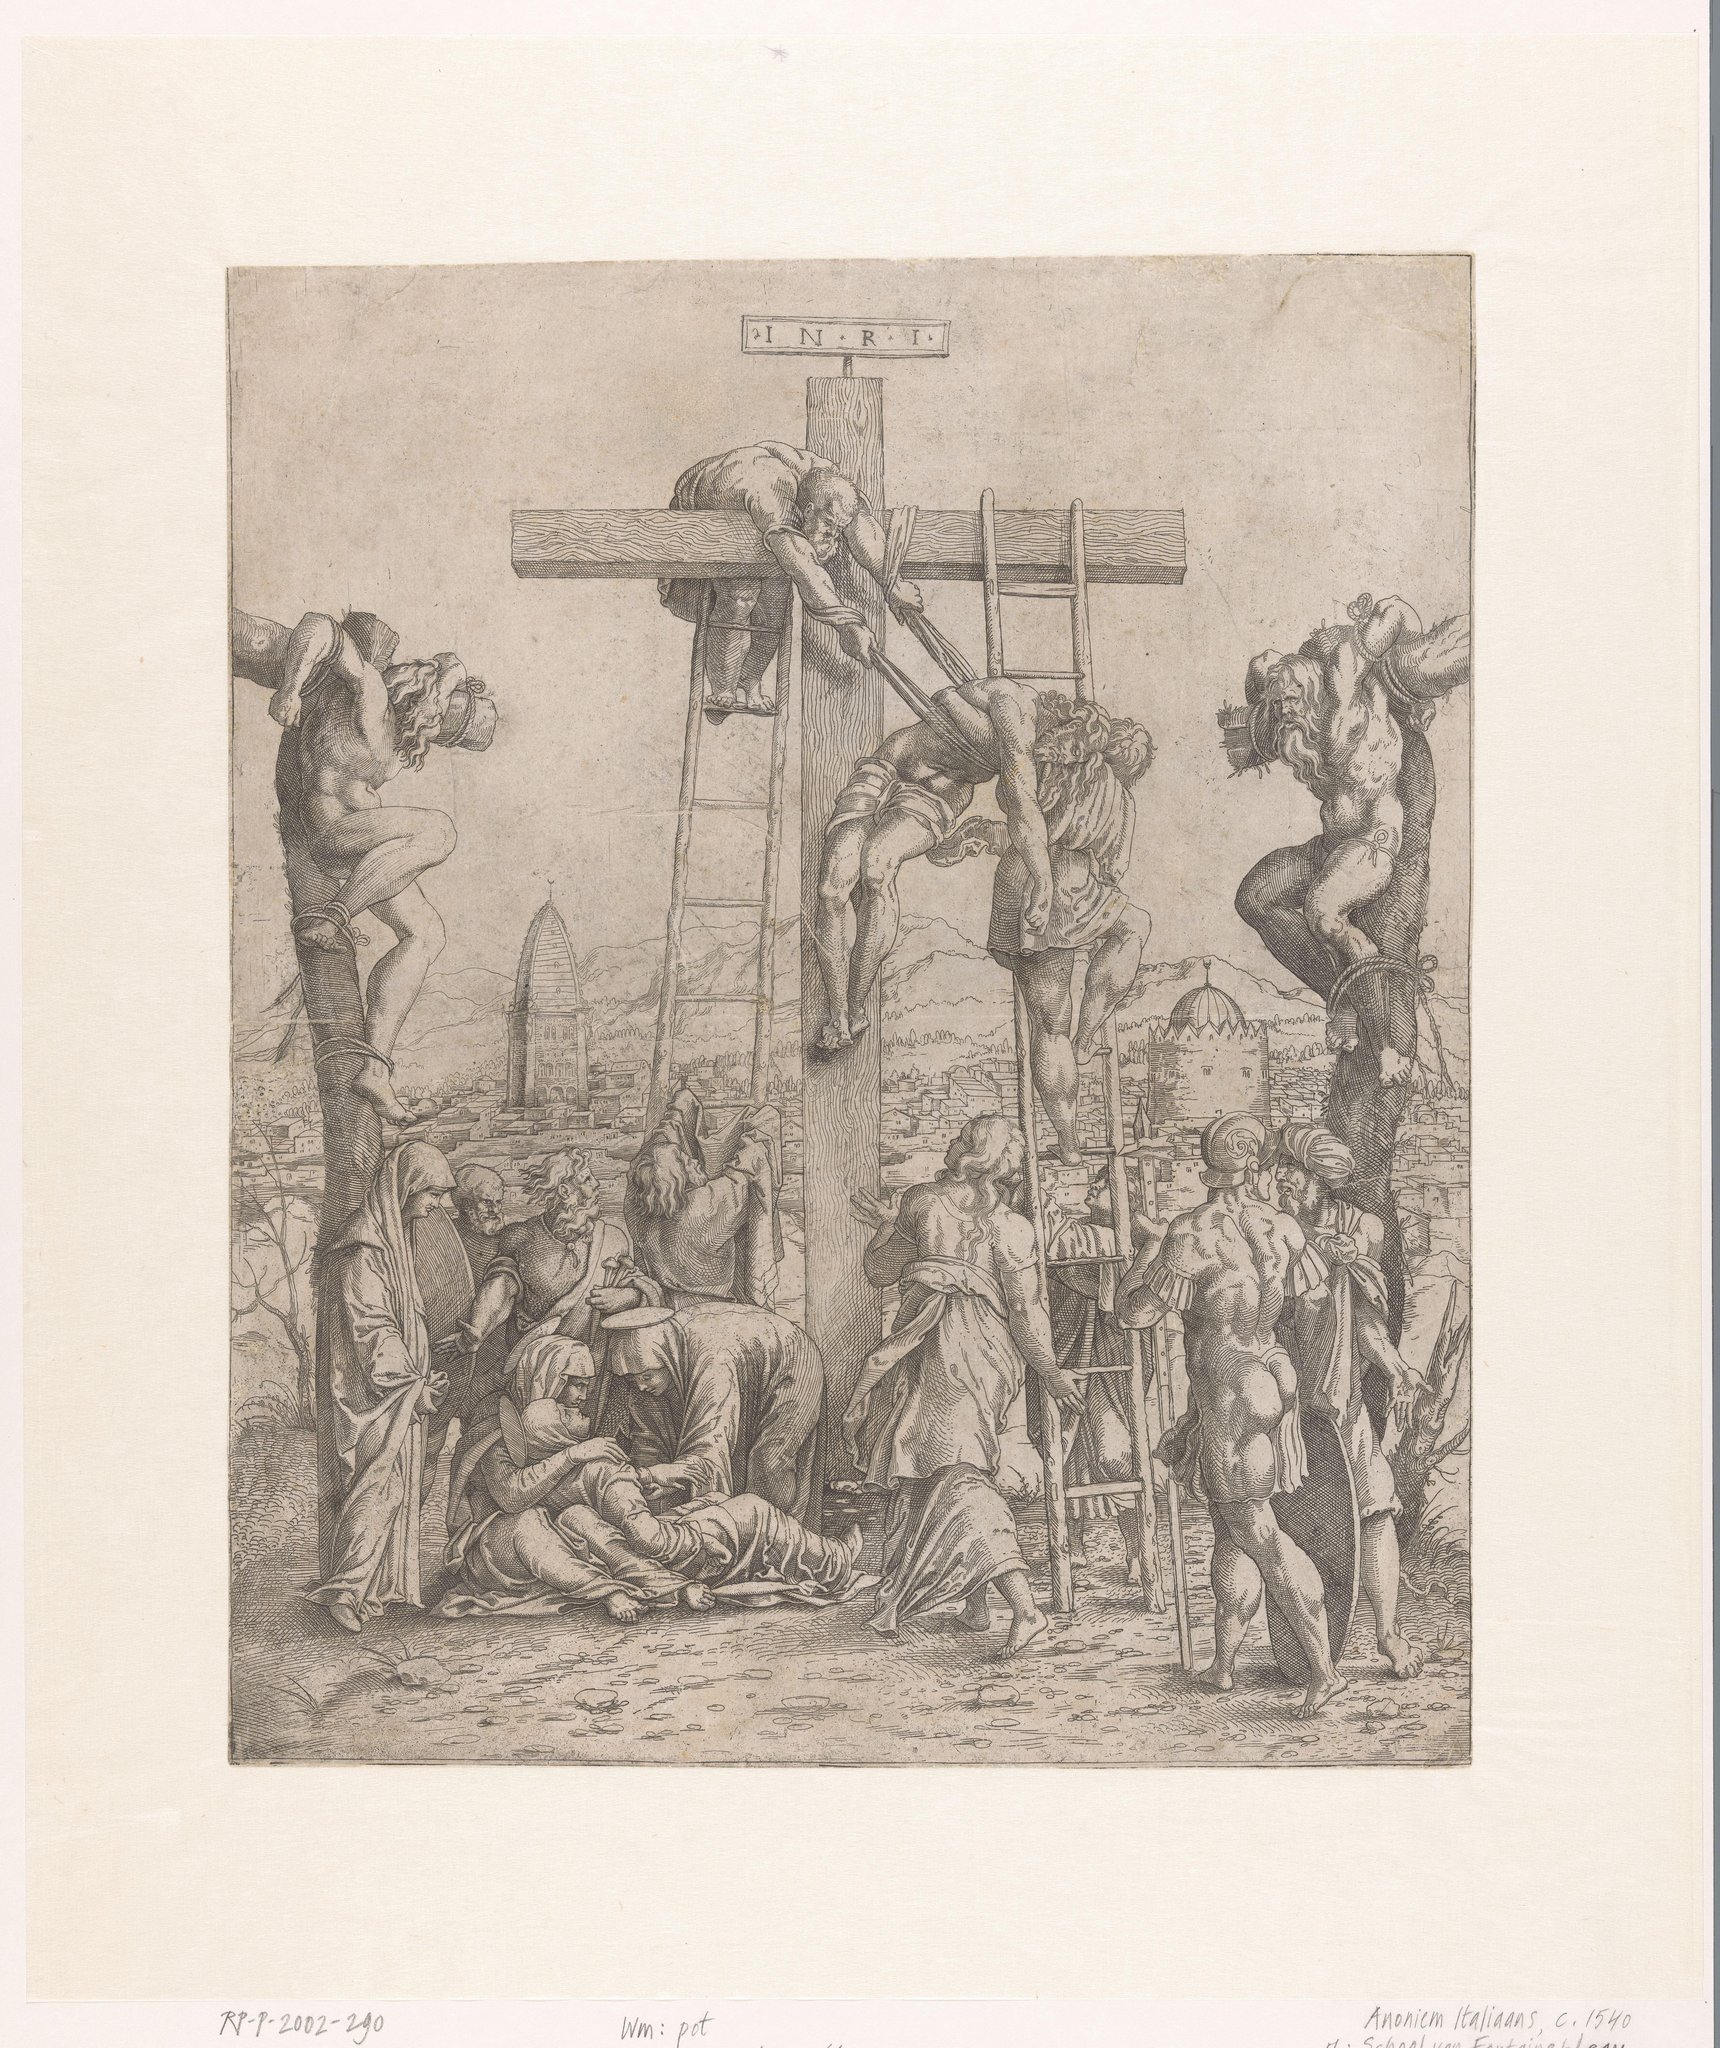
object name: print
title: Kruisafneming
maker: andrea mantegna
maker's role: print maker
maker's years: 1431-1506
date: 1540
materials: paper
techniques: etching, intaglio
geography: italy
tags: descent from the cross: christ is taken down from the cross, usually by nicodemus and joseph of arimathaea who are standing on the ladders (both arms of christ detached)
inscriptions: collector's mark: Lugt 2228, collector's mark: Lugt 2760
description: Het lichaam van Christus wordt van het kruis gehaald door Jozef van Arimatea en Nikodemus. De Maria's treuren onder het kruis. Links en rechts hangen de twee moordenaars nog aan hun kruisen. Op de achtergrond een stad.